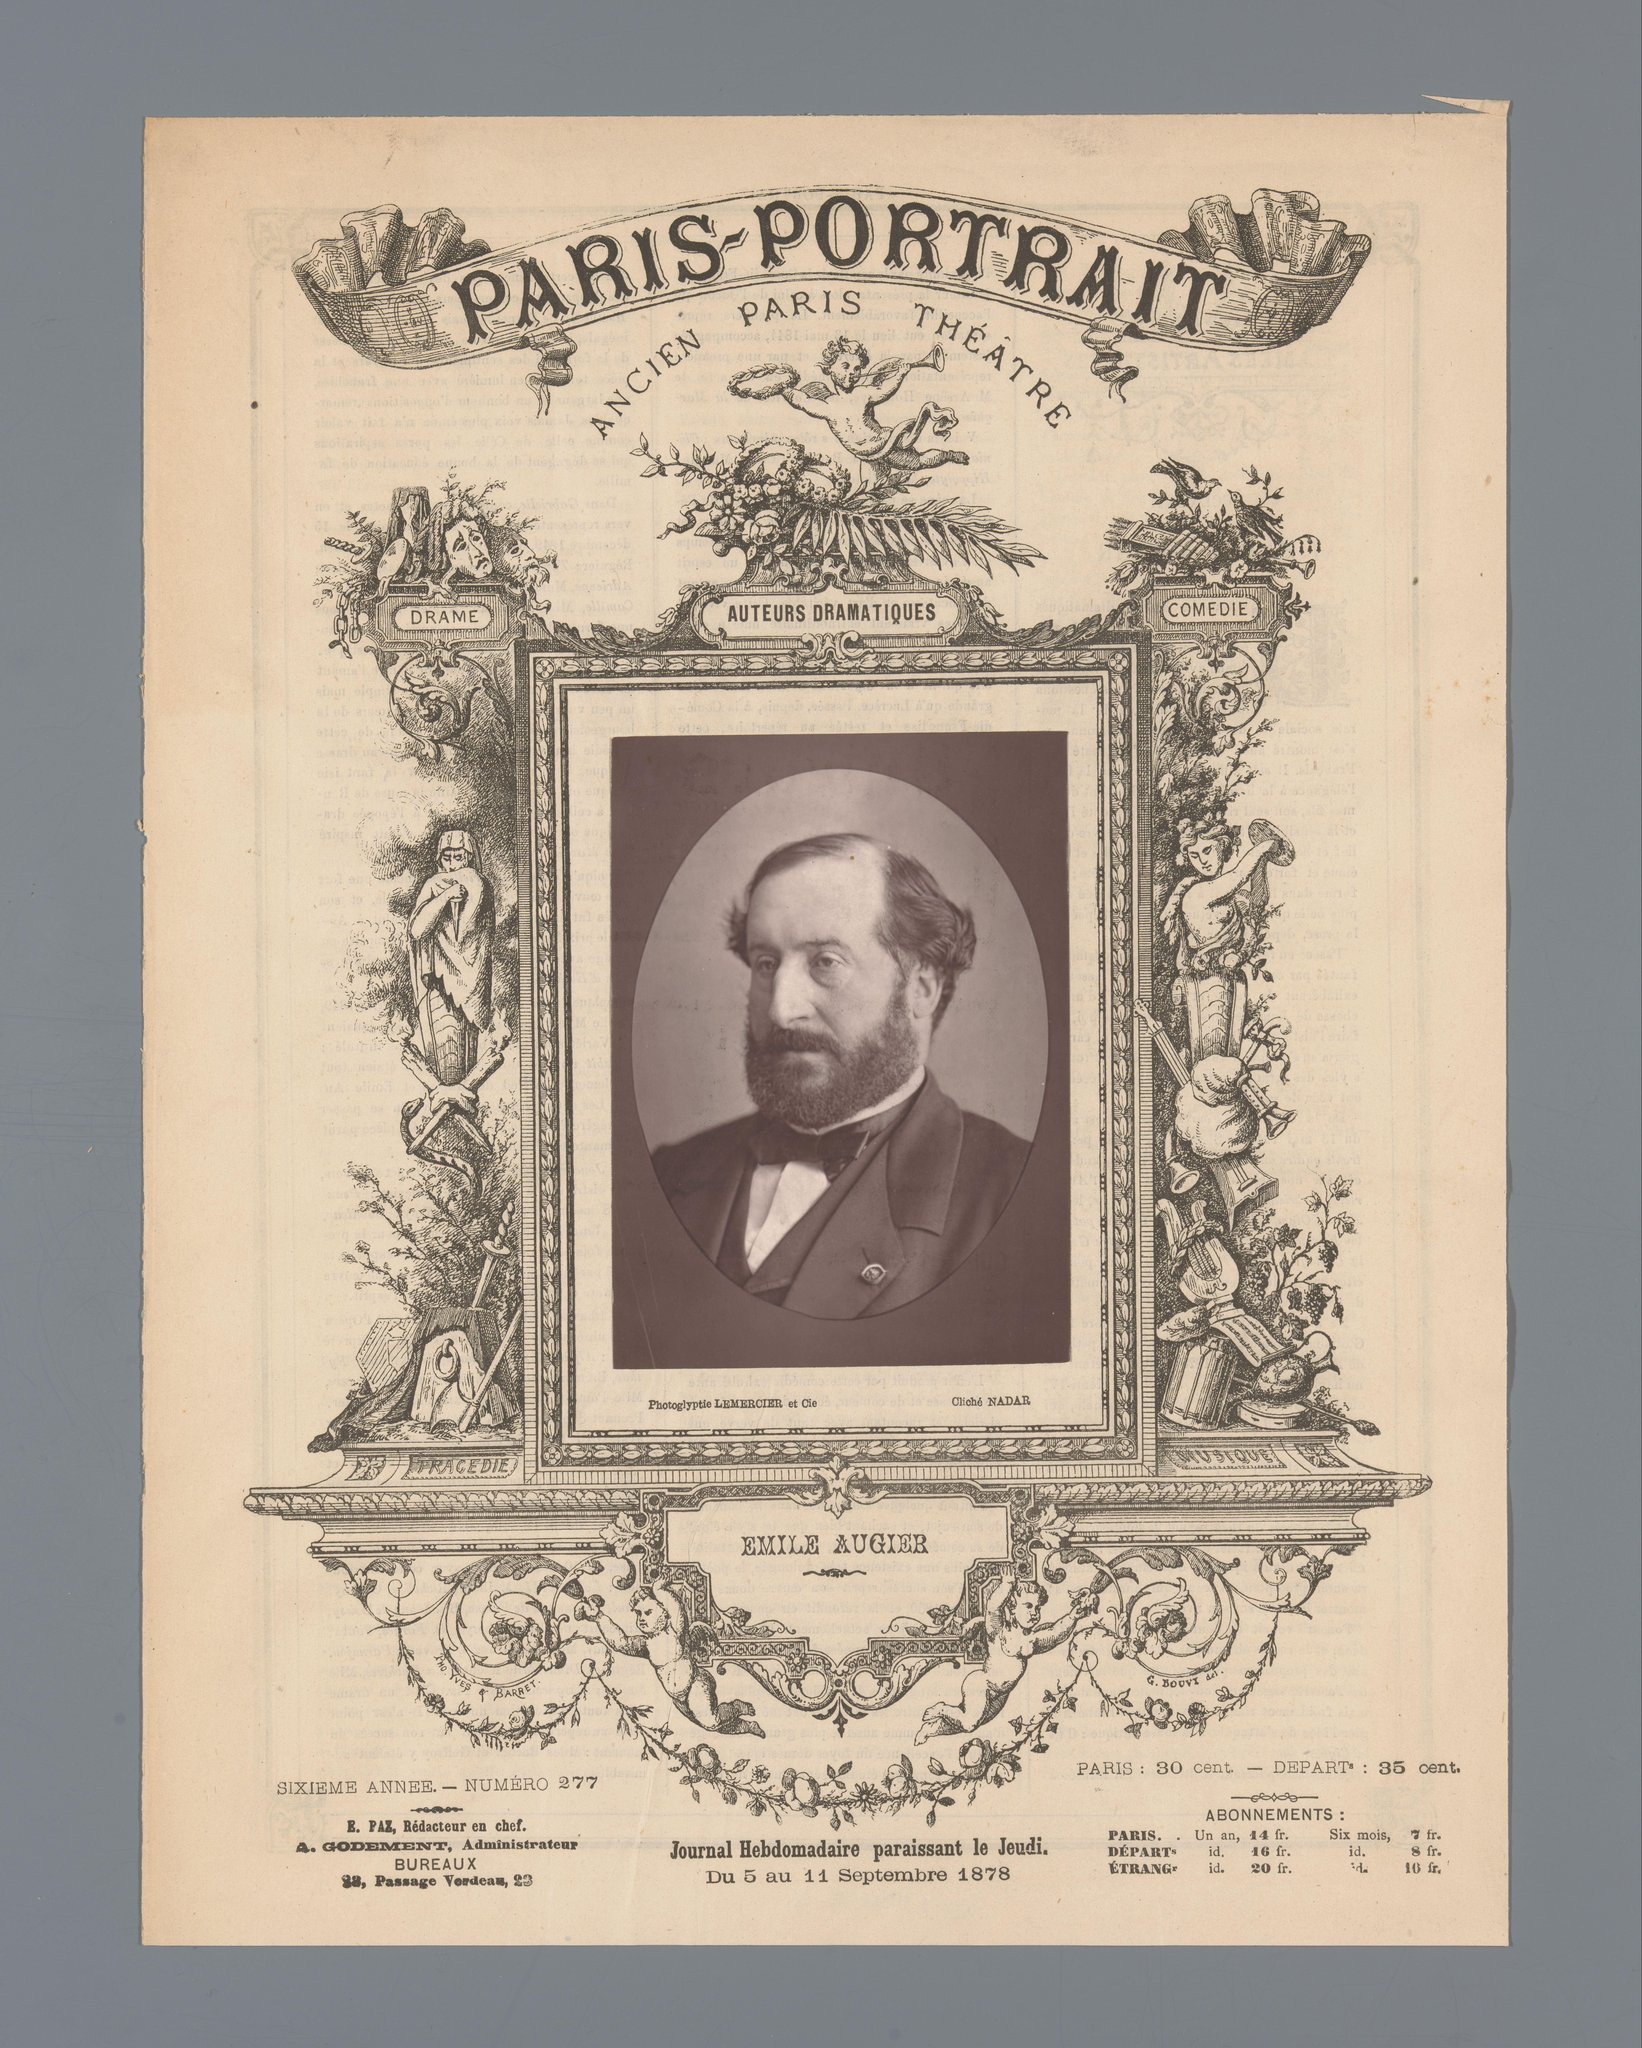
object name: photomechanical print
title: Emile Augier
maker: félix nadar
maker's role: ballonvaarder, fotograaf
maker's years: 1820-1910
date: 1873-1880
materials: paper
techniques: woodburytype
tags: historical persons